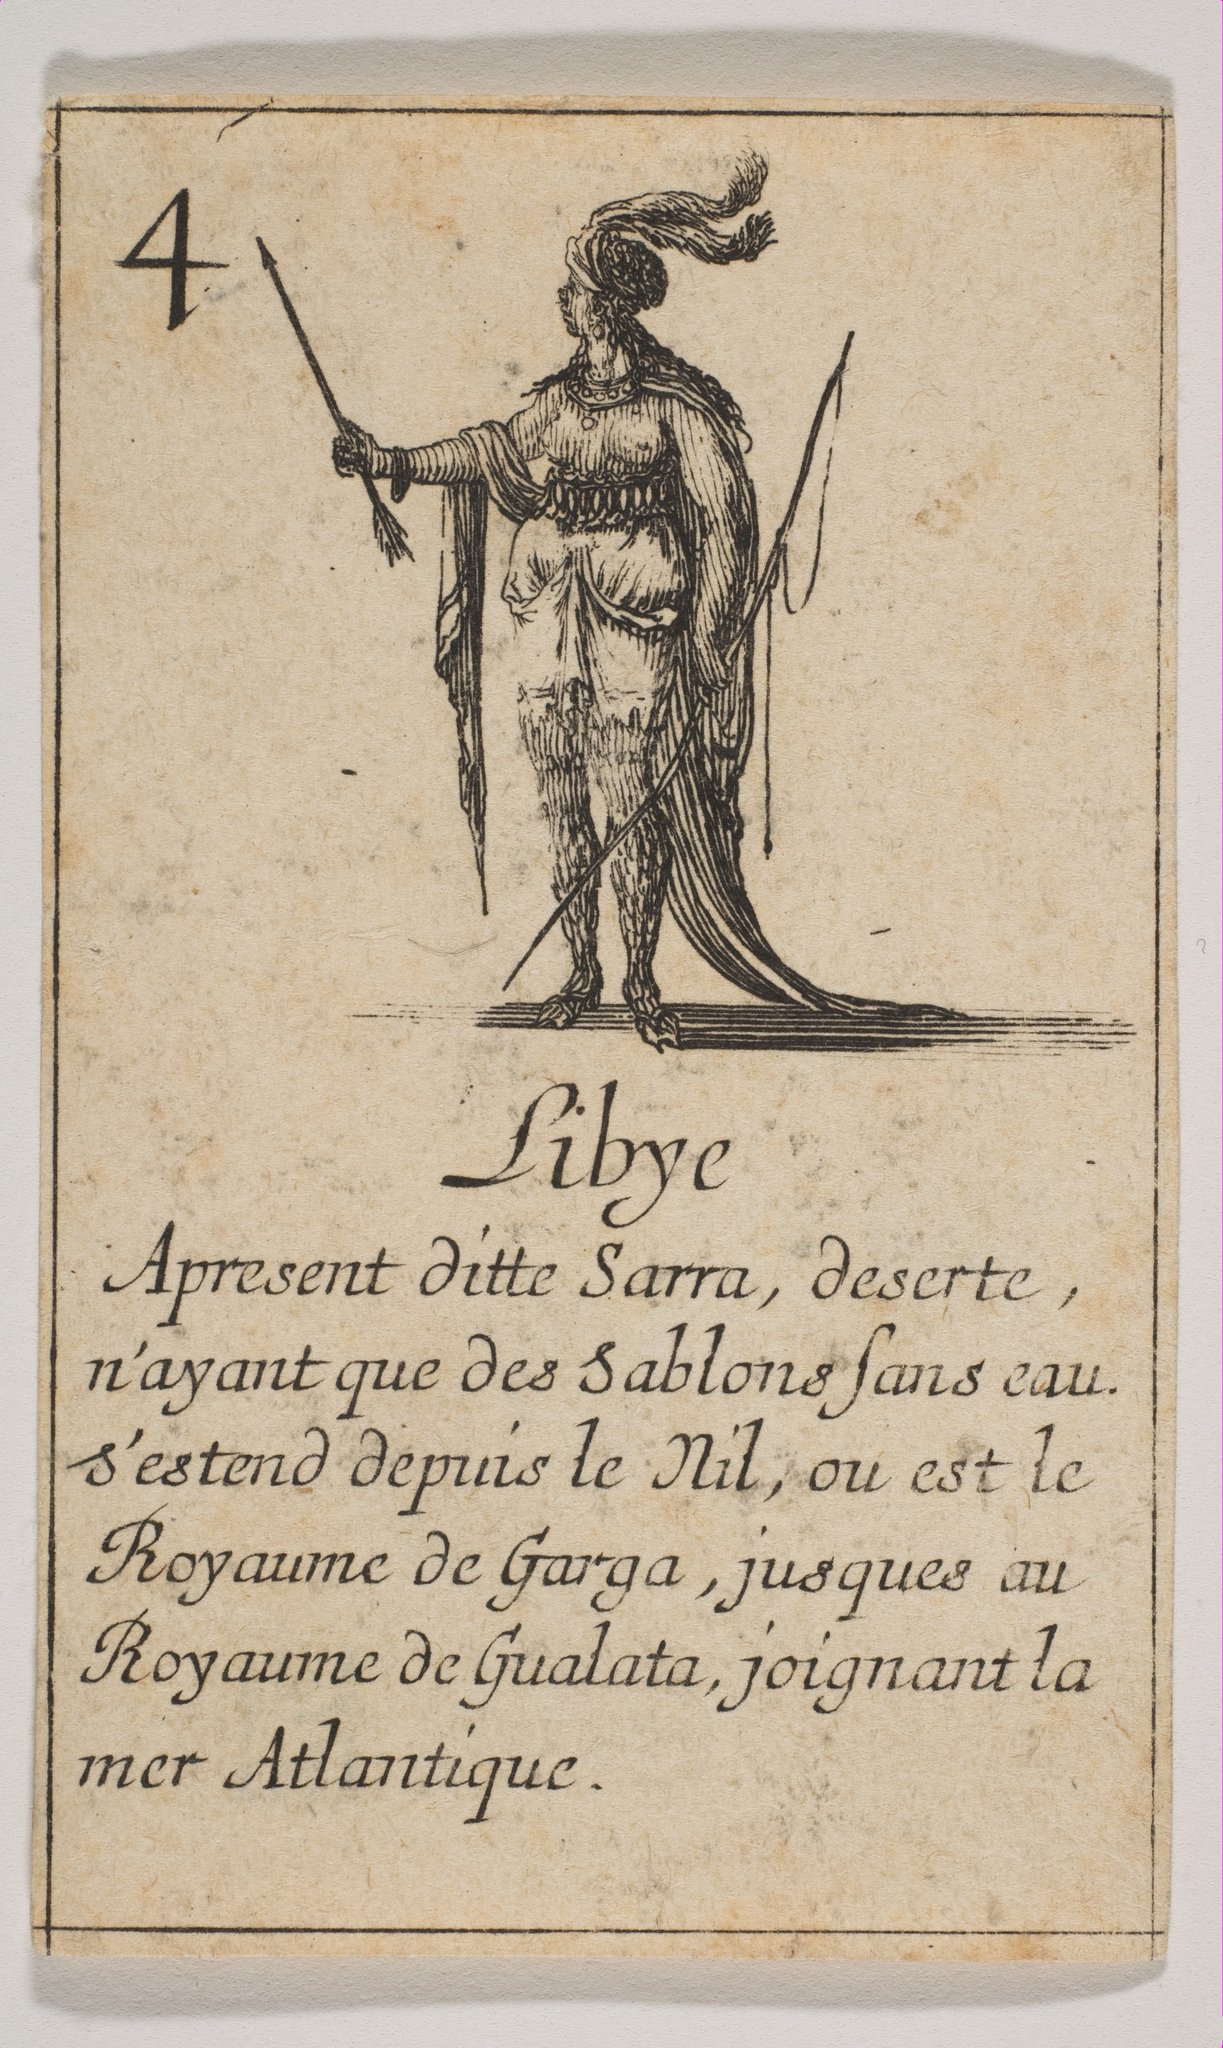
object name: print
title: Libye, from "Jeu de la Géographie"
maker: stefano della bella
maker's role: artist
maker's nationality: italian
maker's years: 1610-1664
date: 1644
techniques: etching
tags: human figures,bow and arrow